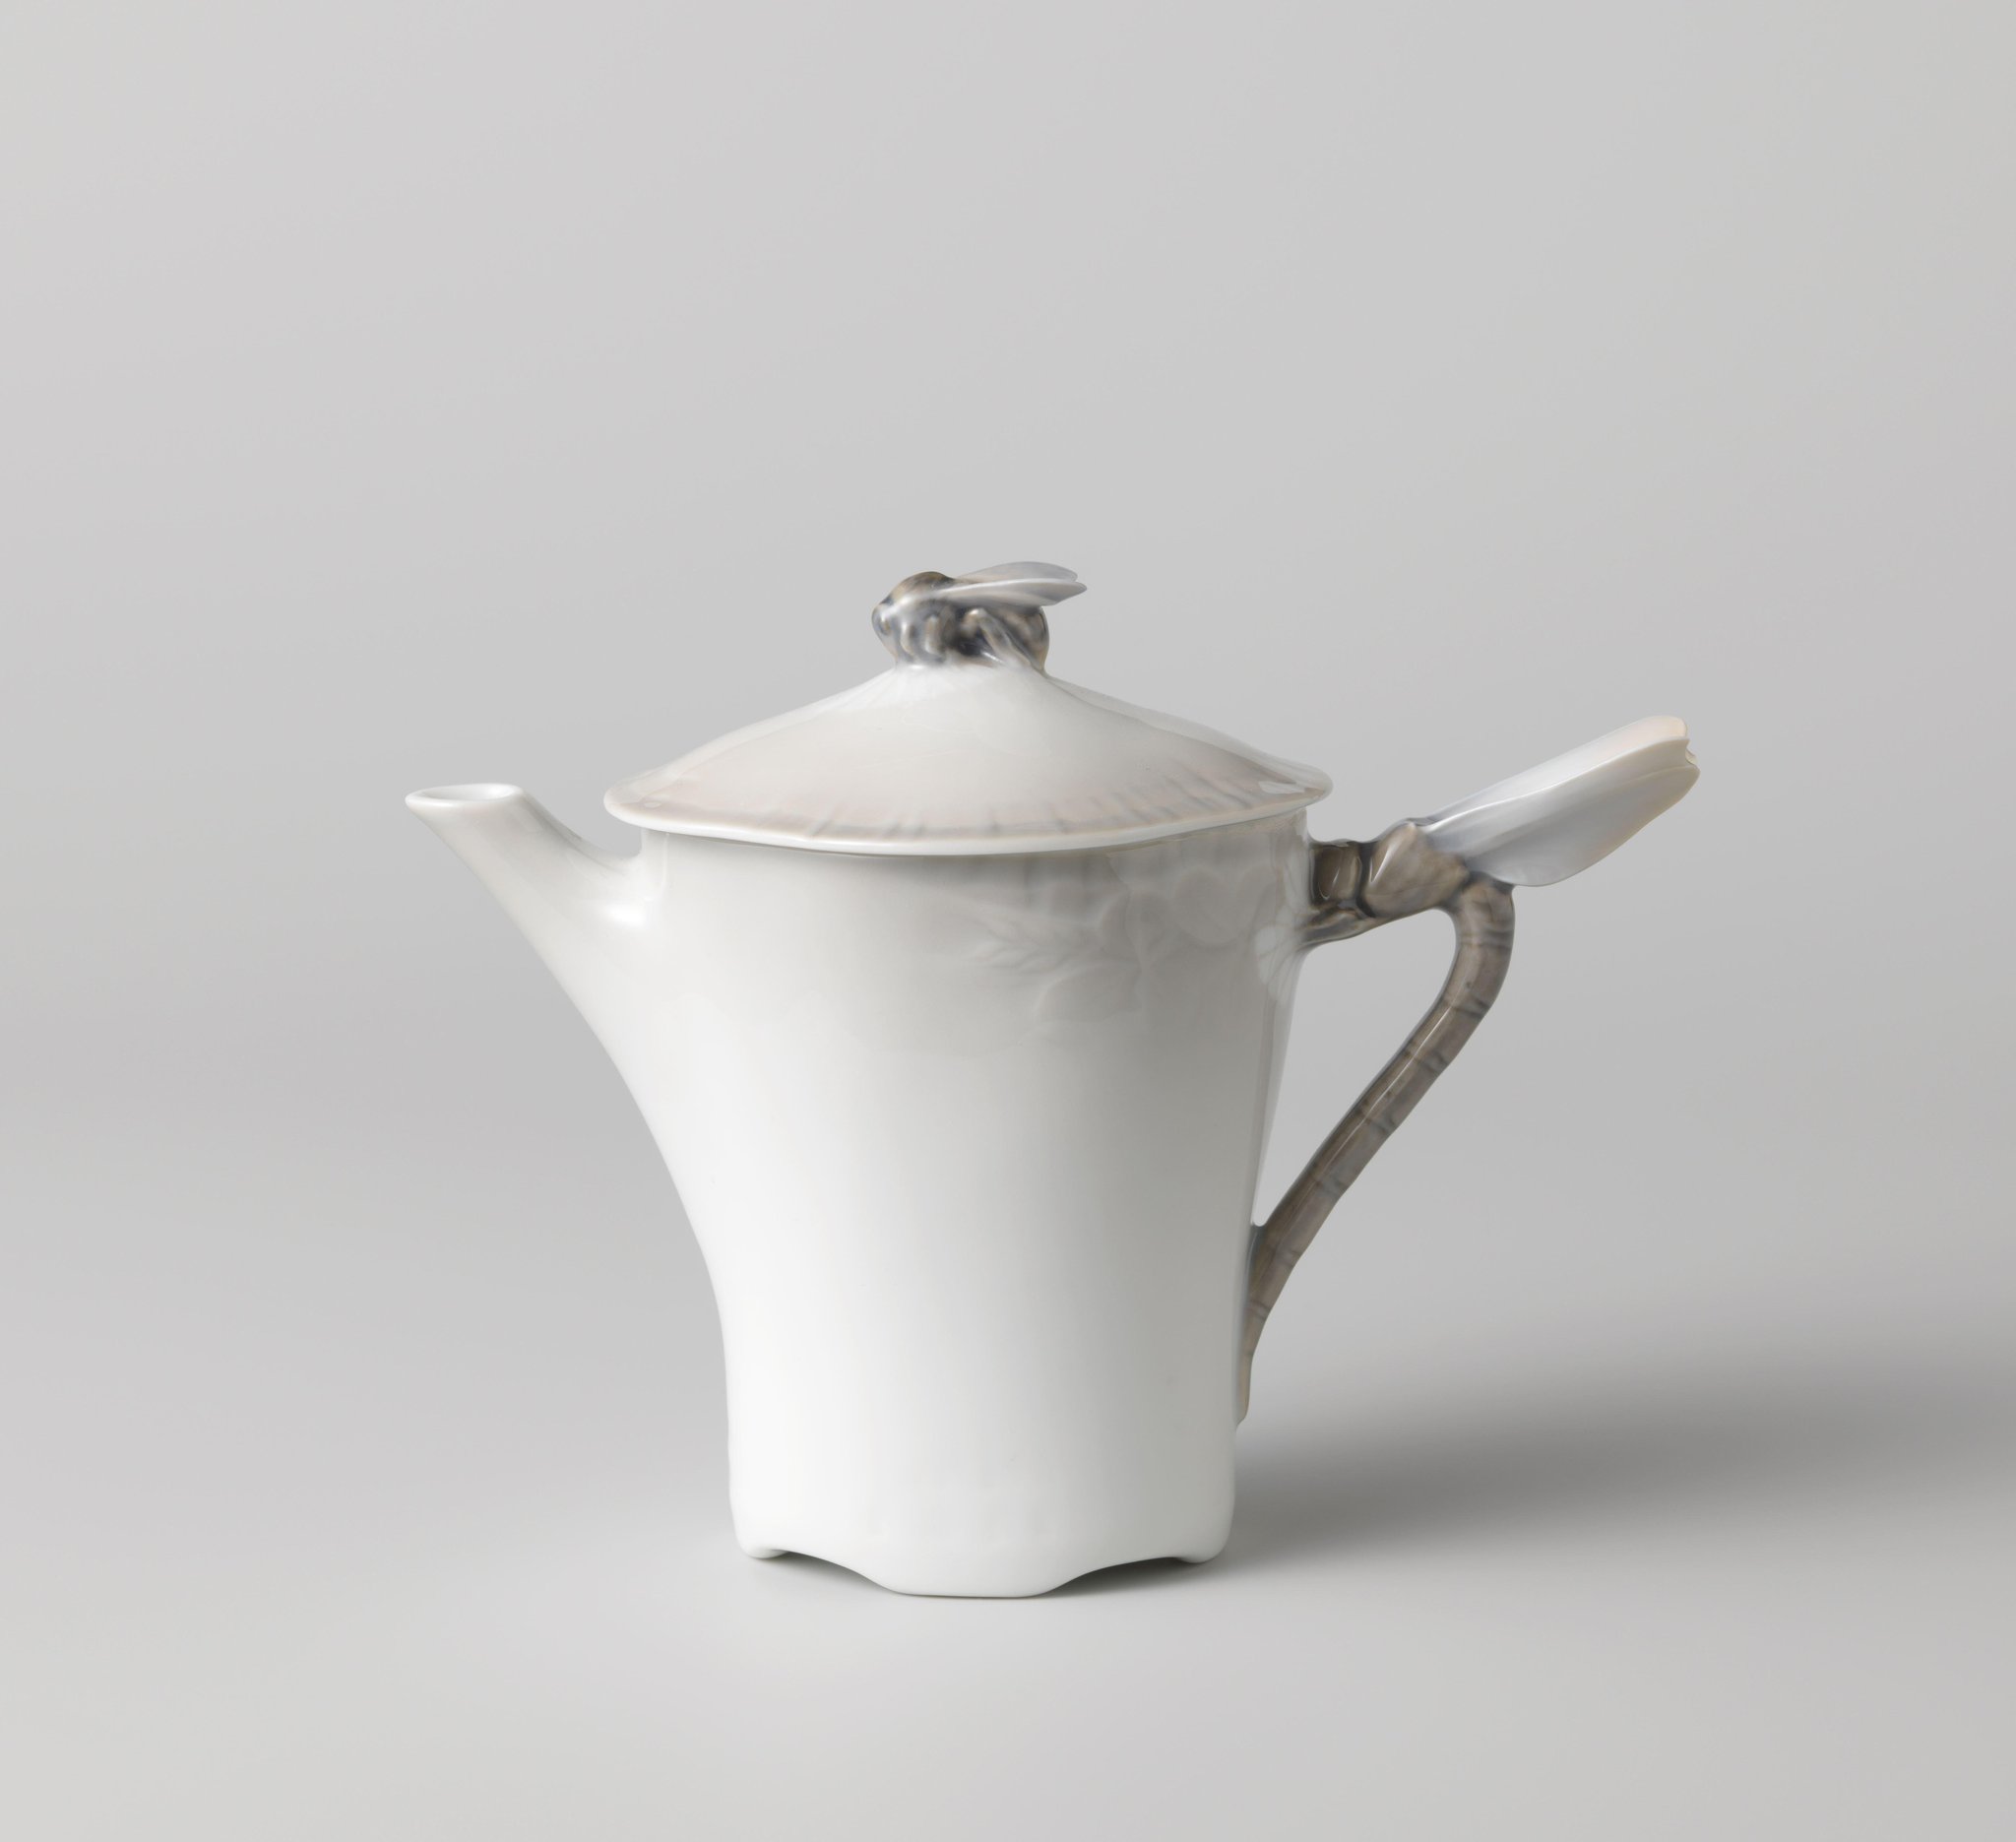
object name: coffee pot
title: Koffiepot met deksel, behorende bij een servies met libellen, vlinders en andere insekten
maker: arnold emil krog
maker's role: ceramicist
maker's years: 1856-1937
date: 1894-1899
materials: porcelain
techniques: painted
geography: copenhagen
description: Parts of a tea and coffee service. Porcelain. Copenhagen, Den Kongelig Porcelainfabrik, c. 1894 - 1899, designed by Arnold Krog.